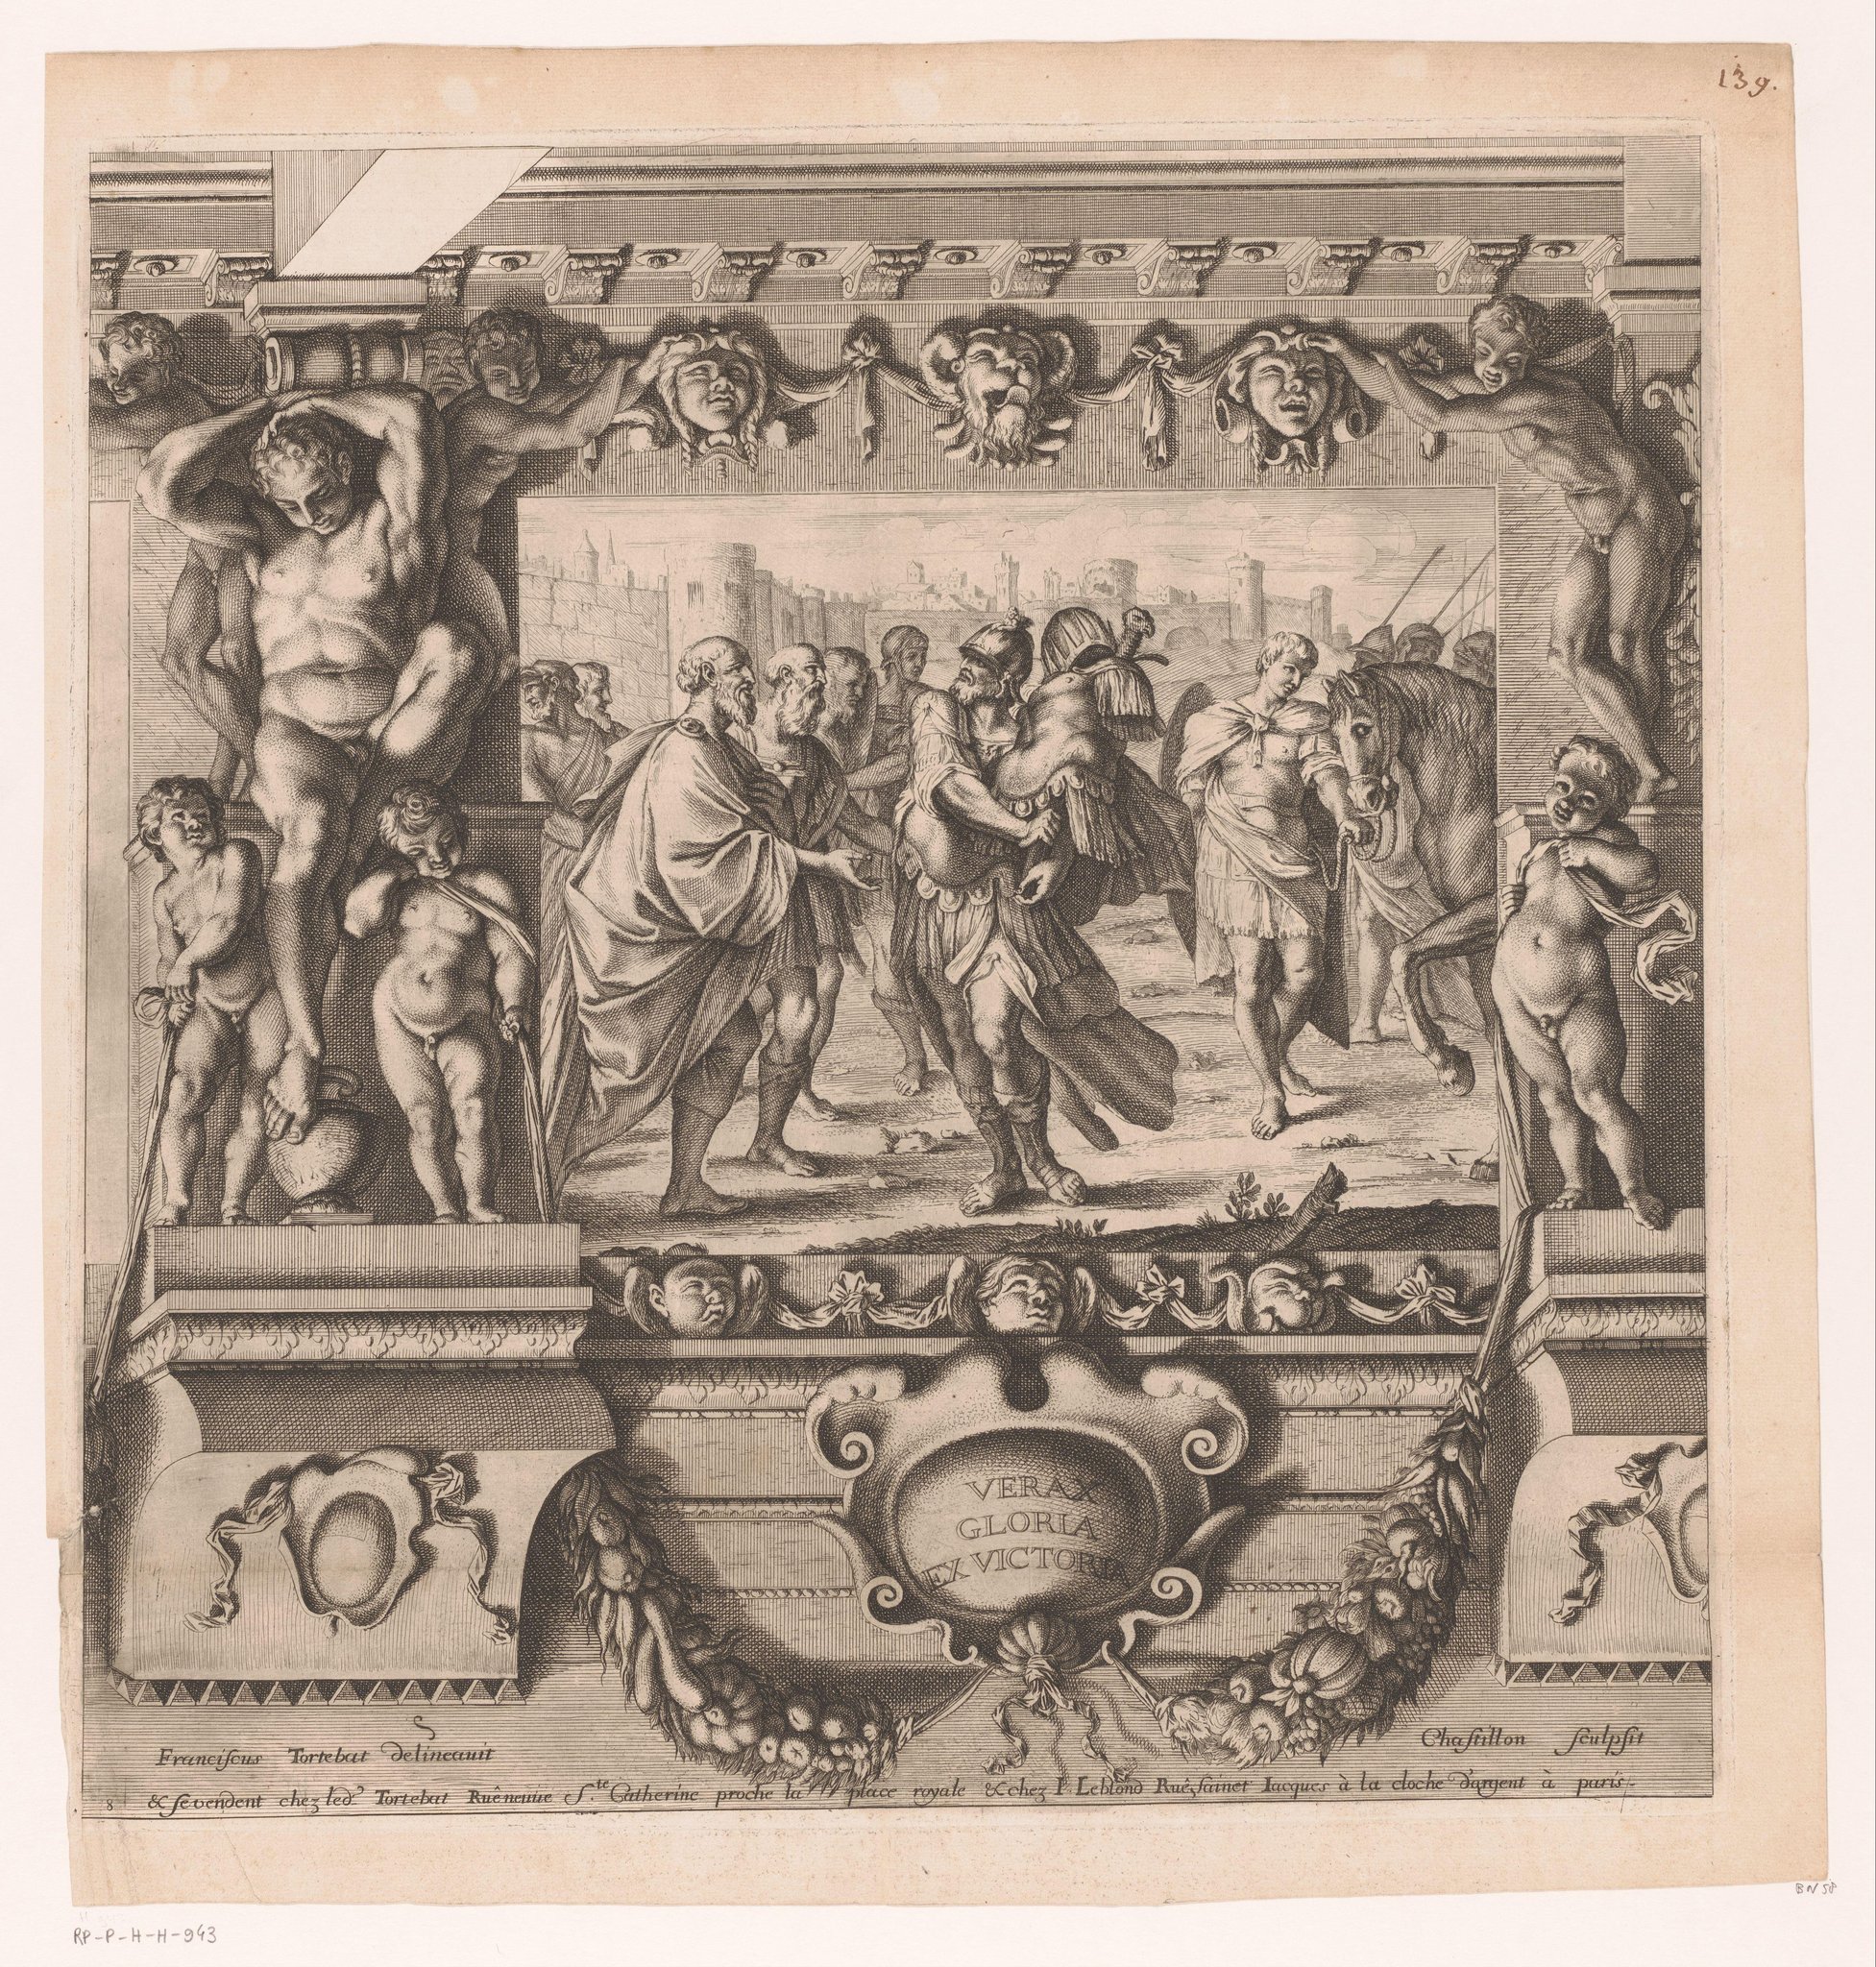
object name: print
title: Verhaal van Romulus en Remus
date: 1659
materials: paper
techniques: engraving, etching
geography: paris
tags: (story of) romulus and remus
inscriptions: number: ‘139.’, number: ‘140.’, collector's mark: Lugt 11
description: Maakt deel uit van een 14-delige serie met scènes uit het verhaal van Romulus en Remus naar ontwerpen door de familie Carracci voor het Palazzo Magnani te Bologna. Prent 1 t/m 7 zijn in prent gebracht door Lepautre en Boulanger en prent 8 t/m 14 door De Châtillon.